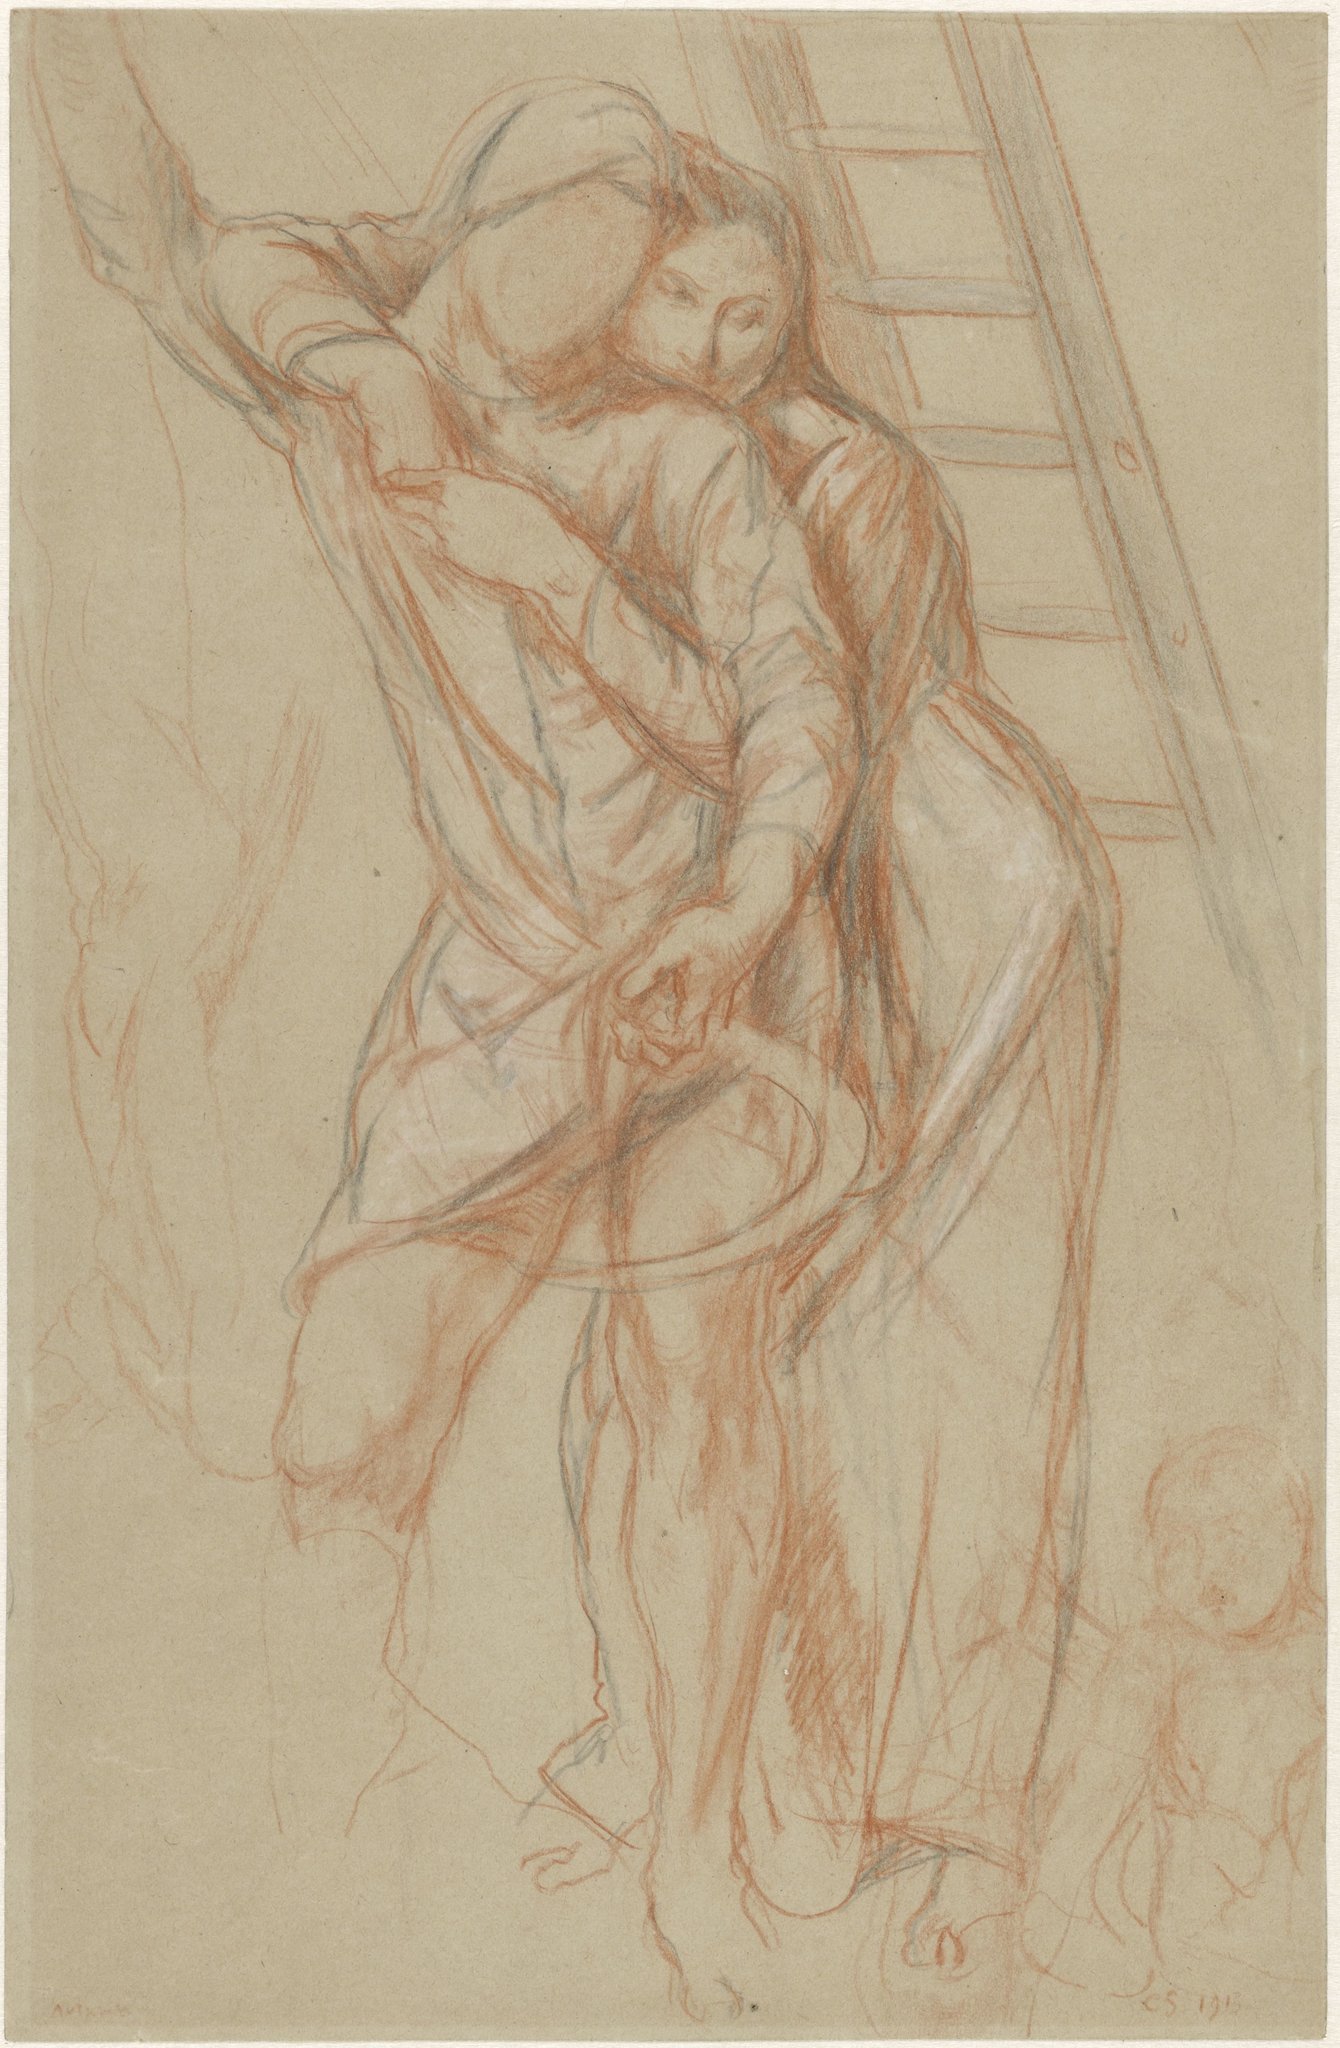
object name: drawing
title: Autumn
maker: charles haslewood shannon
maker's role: draughtsman, print maker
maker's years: 1865-1937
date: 1913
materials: chalk, paper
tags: harvest, (lovers) embracing each other, 'symplegma', agricultural implements: sickle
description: Een vrouw omhelst een man staande leunend tegen een boom met een sikkel; achter staat een ladder en op de voorgrond een zittend kind.